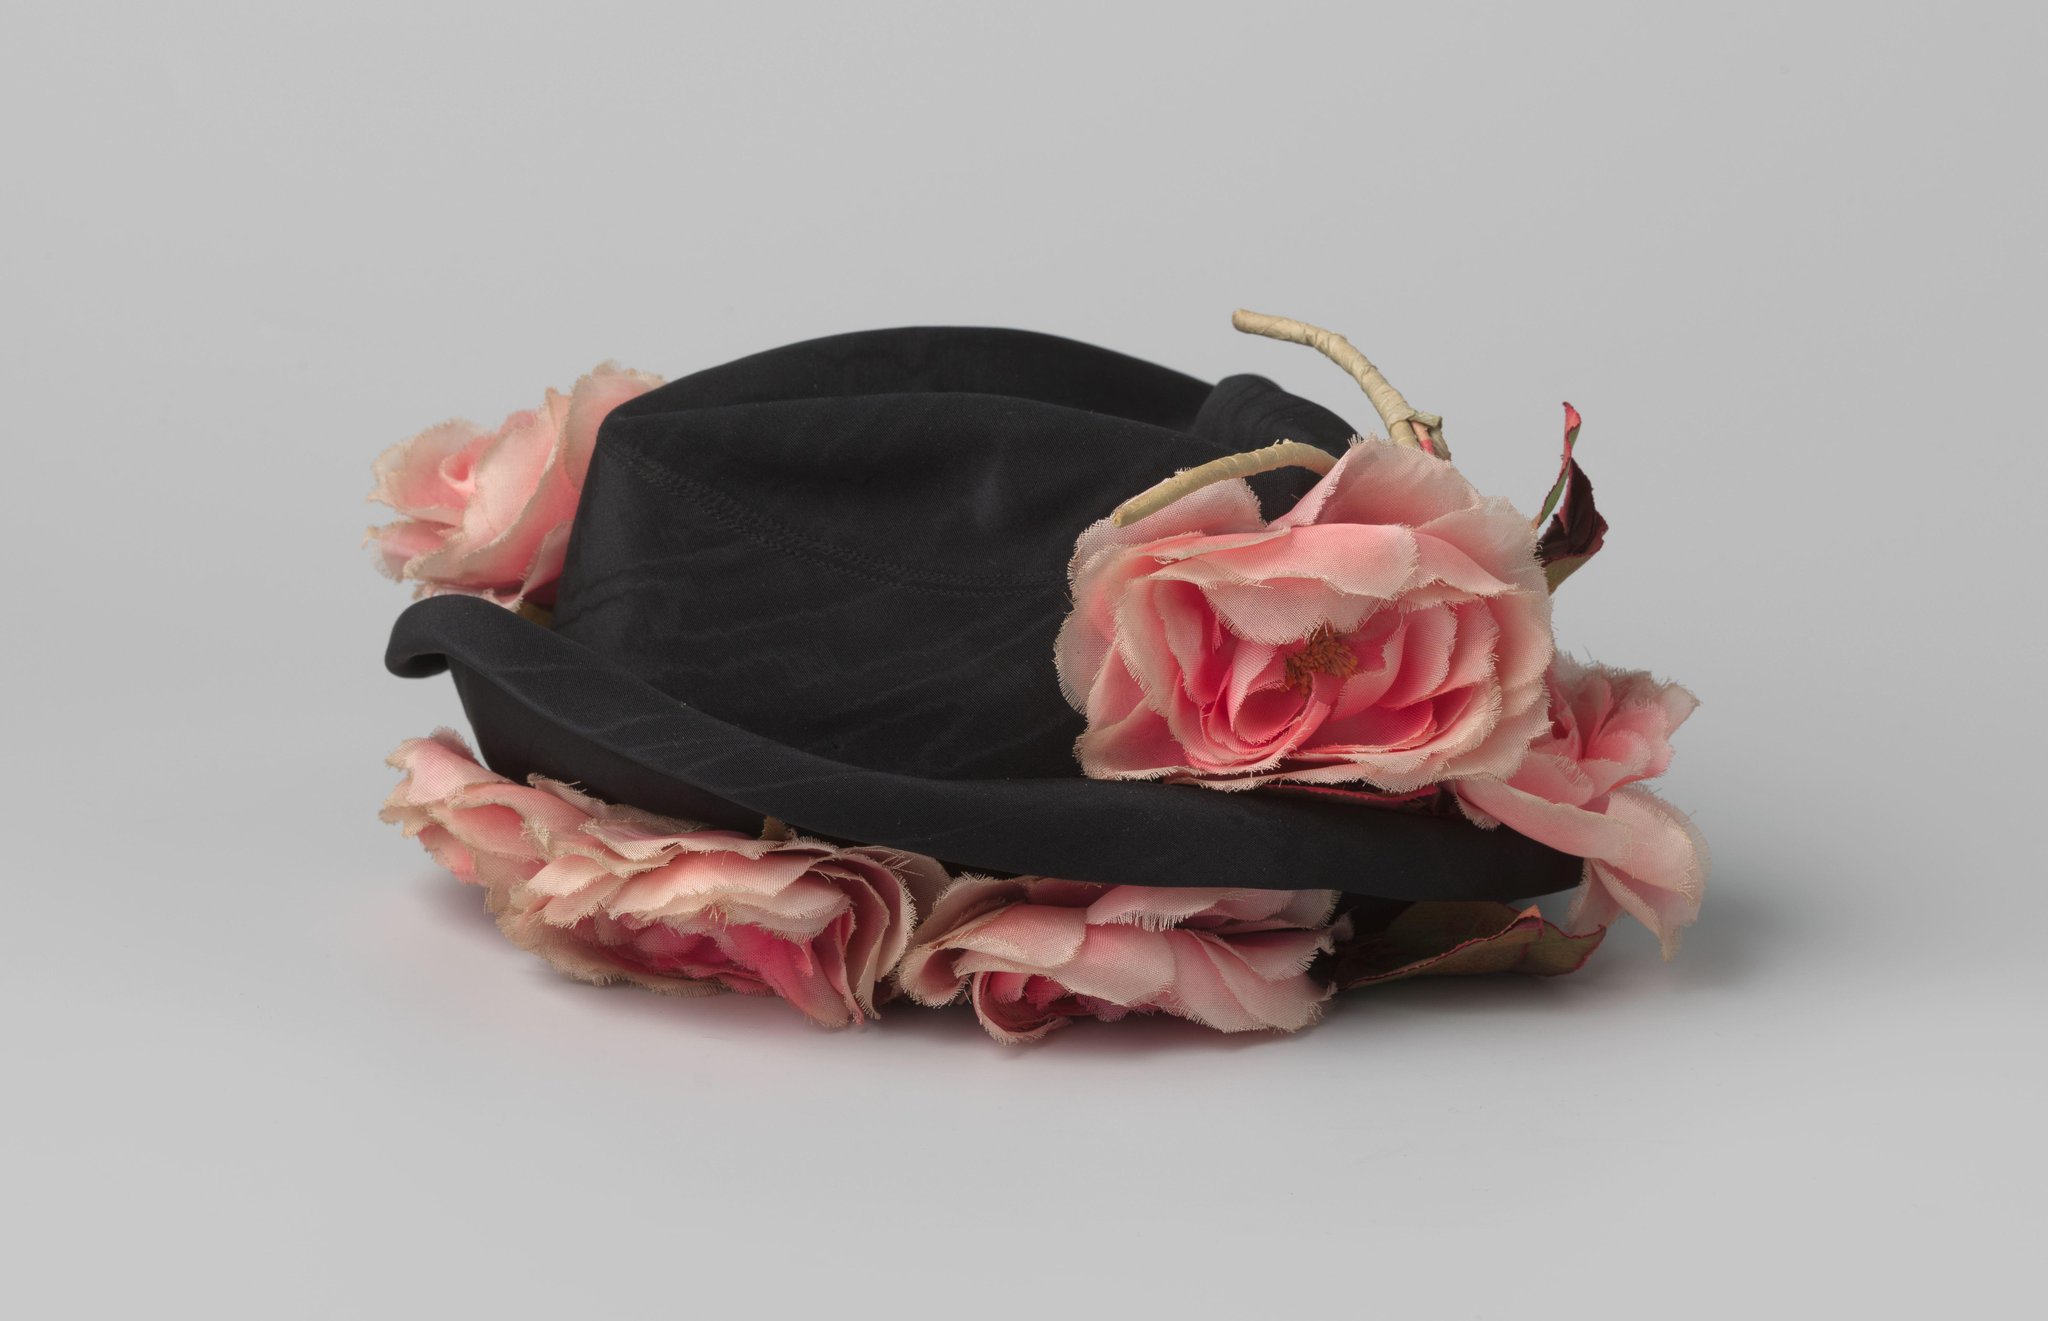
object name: womenswear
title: Hoed van zwarte, gewatteerde ripszijde met opstaande rand aan de achterkant (zgn. relevé), versierd met zes roze rozen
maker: elsa schiaparelli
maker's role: modeontwerper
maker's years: 1890-1973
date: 1948-1952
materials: silk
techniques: padding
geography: paris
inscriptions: mark: ‘Schiaparelli / place vendôme Paris’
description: Hoed van zwarte, gewatteerde ripszijde met opstaande rand aan de achterkant (zgn. relevé), versierd met zes roze rozen; drie onder de rand en drie tegen de bol.